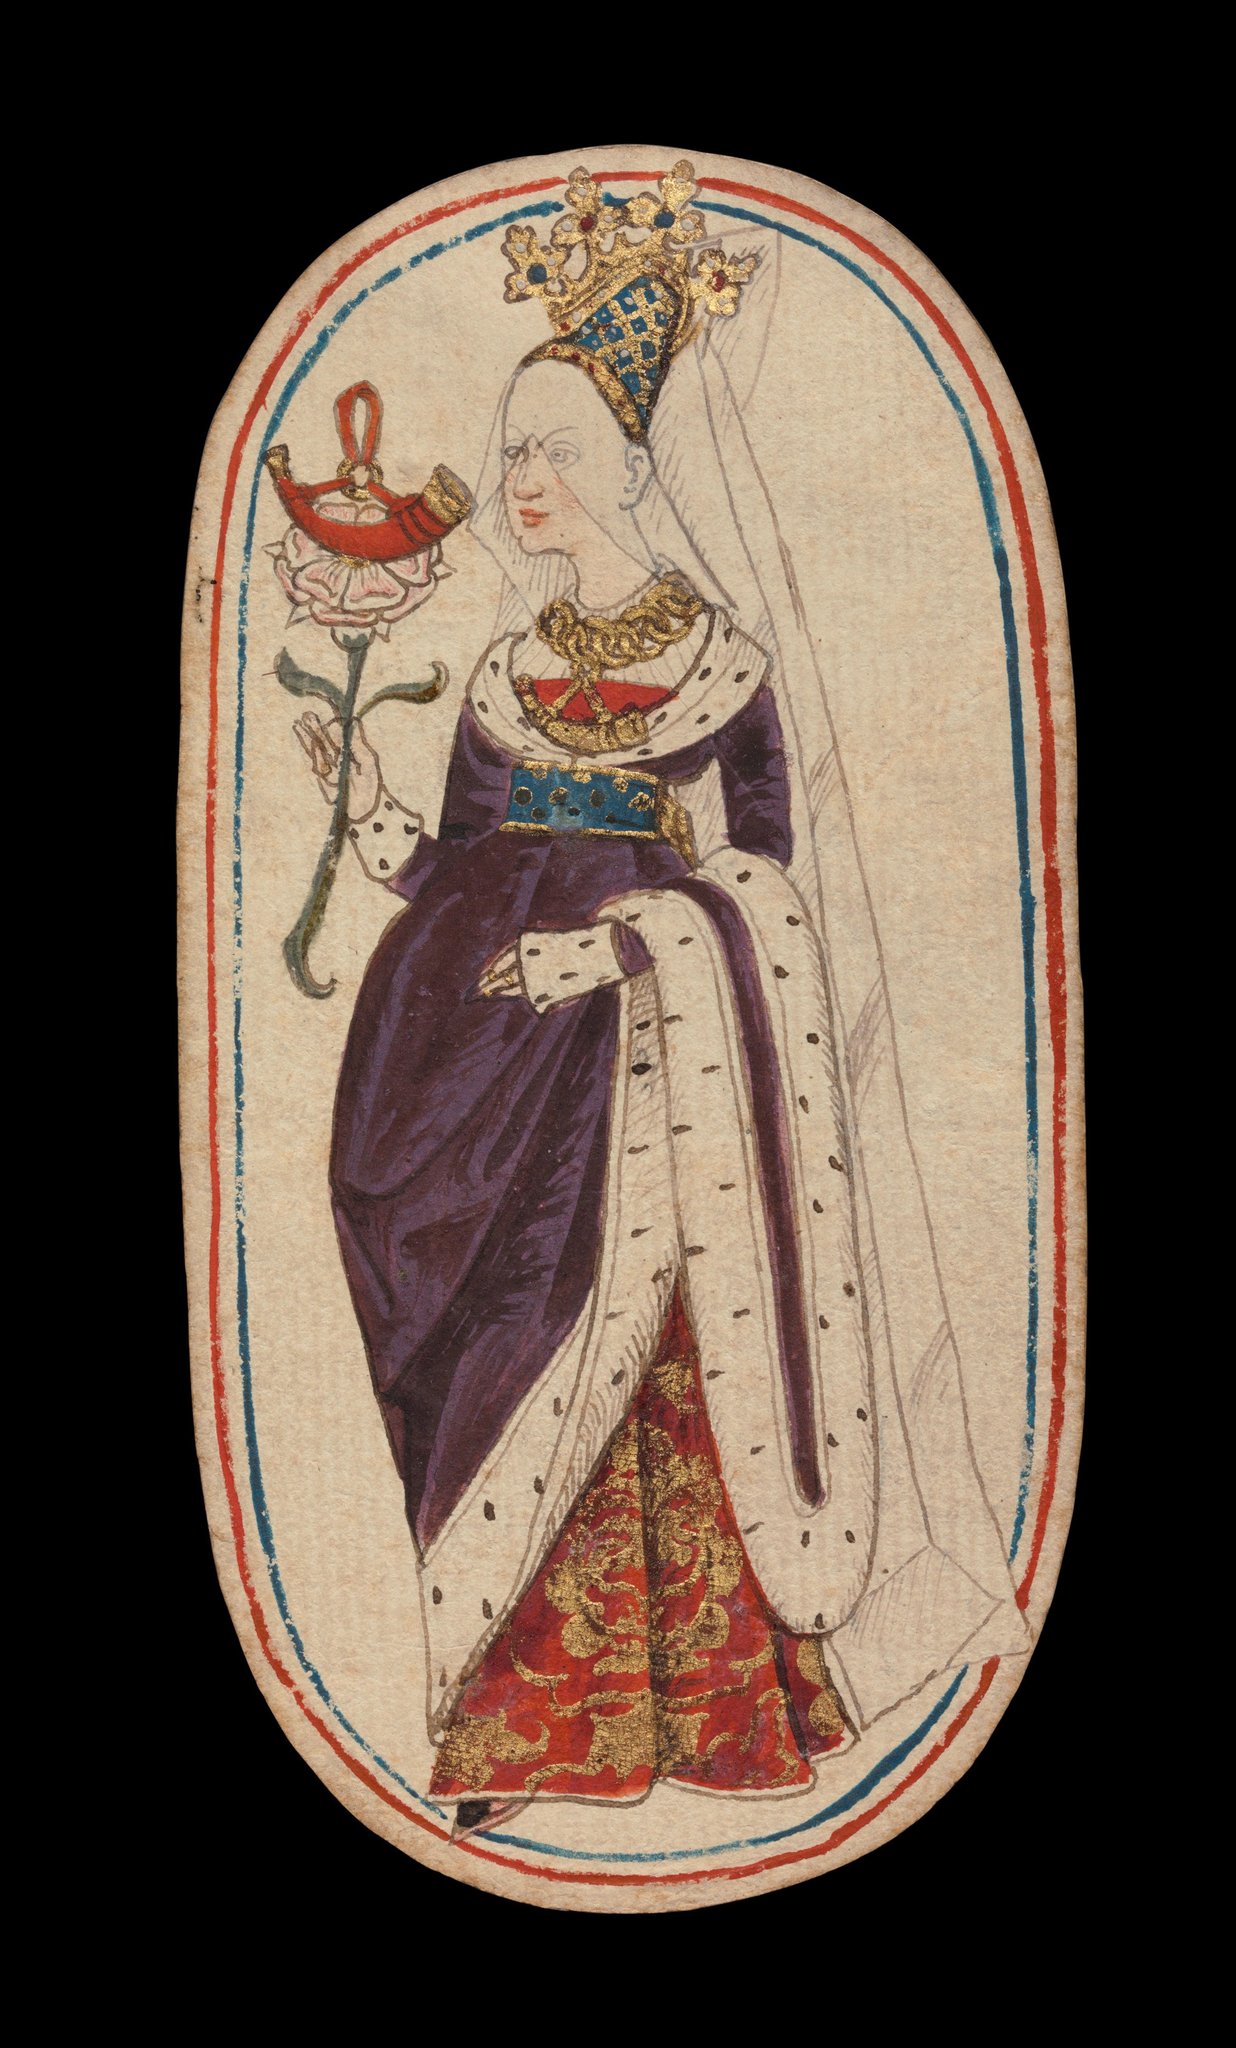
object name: playing card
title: Queen of Horns, from The Cloisters Playing Cards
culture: south netherlandish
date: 1475-1480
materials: glaze, gold, ink, paint, paper, silver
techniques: pen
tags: queens,playing cards,horns,games